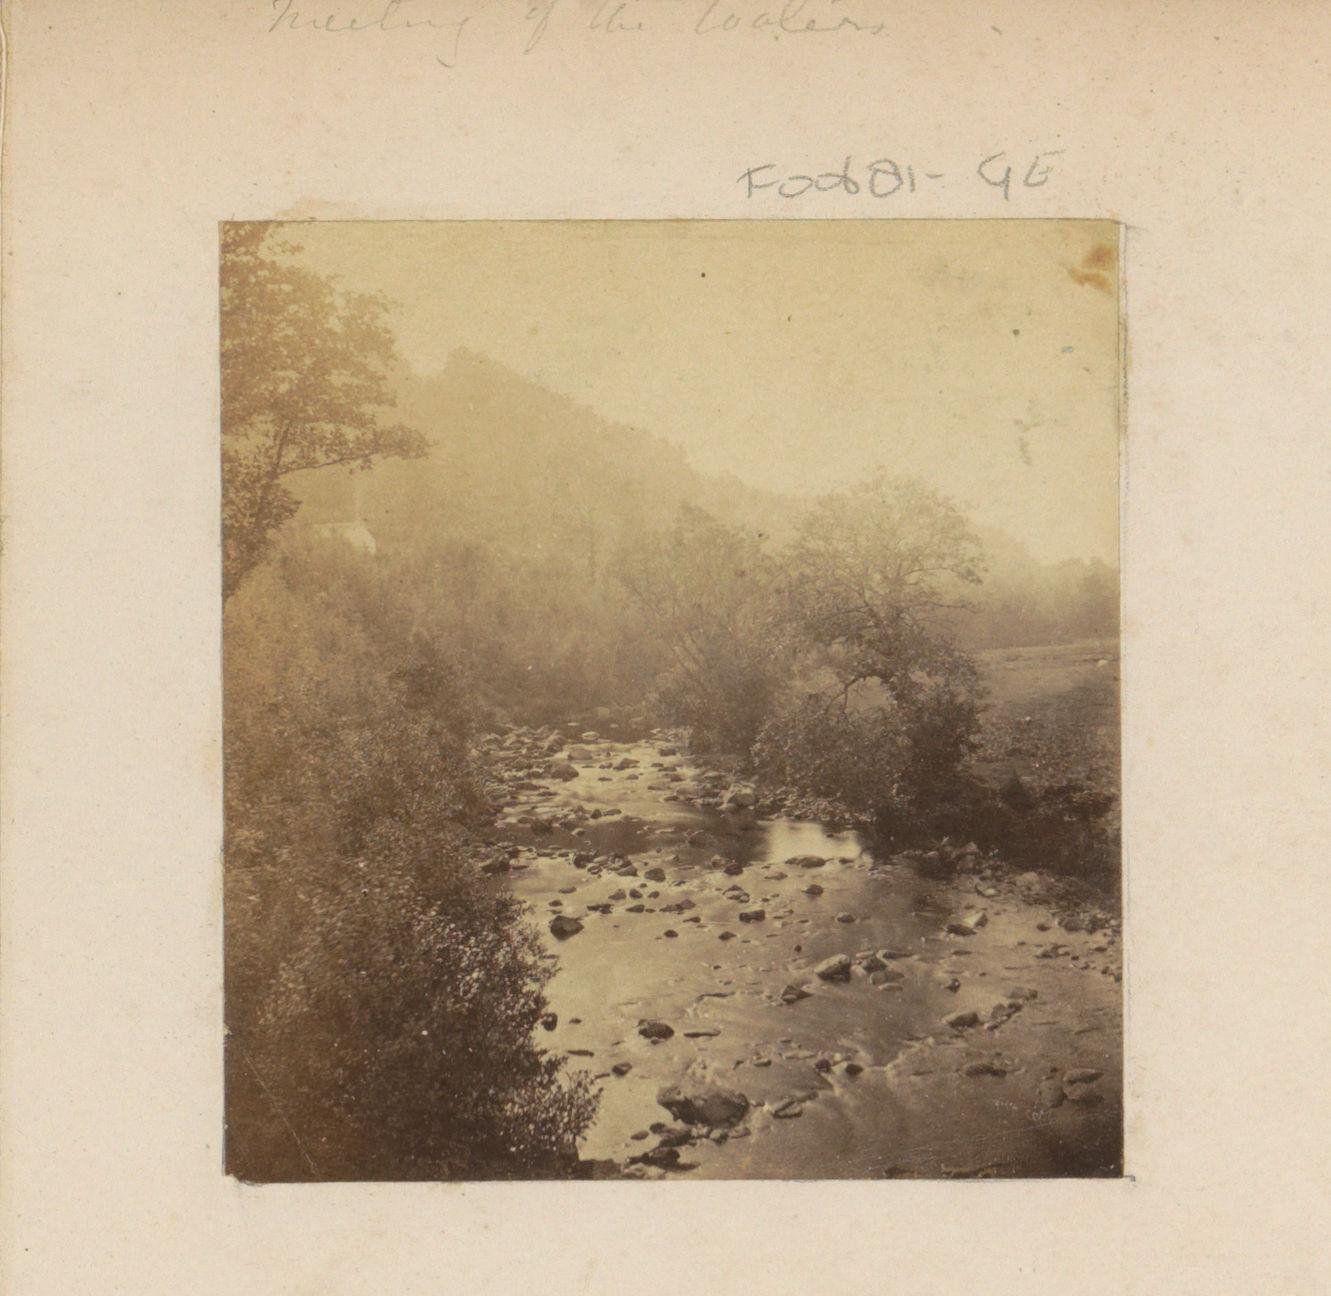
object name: photograph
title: Rivierlandschap in Engeland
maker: Anonymous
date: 1850-1870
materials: paper, photographic support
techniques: albumen print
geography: england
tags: landscapes with waters, waterscapes, seascapes (in the temperate zone) (+ landscape with figures, staffage), england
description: Onderdeel van Album met foto's van bezienswaardigheden en landschappen in Engeland en van kunst.